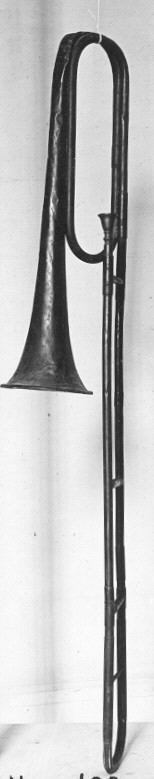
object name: trombone non functional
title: Trombone (Non-functional)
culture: italian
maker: leopoldo franciolini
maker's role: maker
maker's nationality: italian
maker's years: 1844-1920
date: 1800-1889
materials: brass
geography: italy